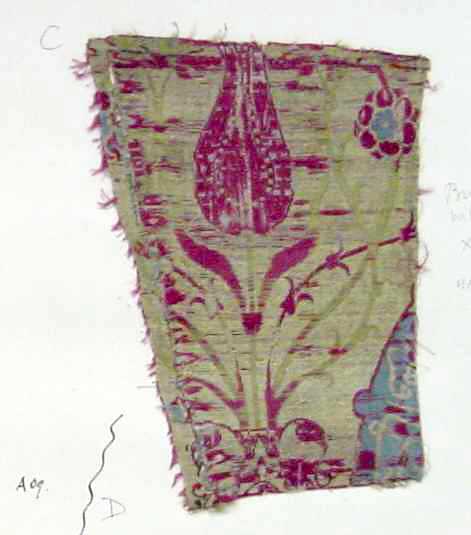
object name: textile fragment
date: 1501-1700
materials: metal thread, silk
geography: turkey